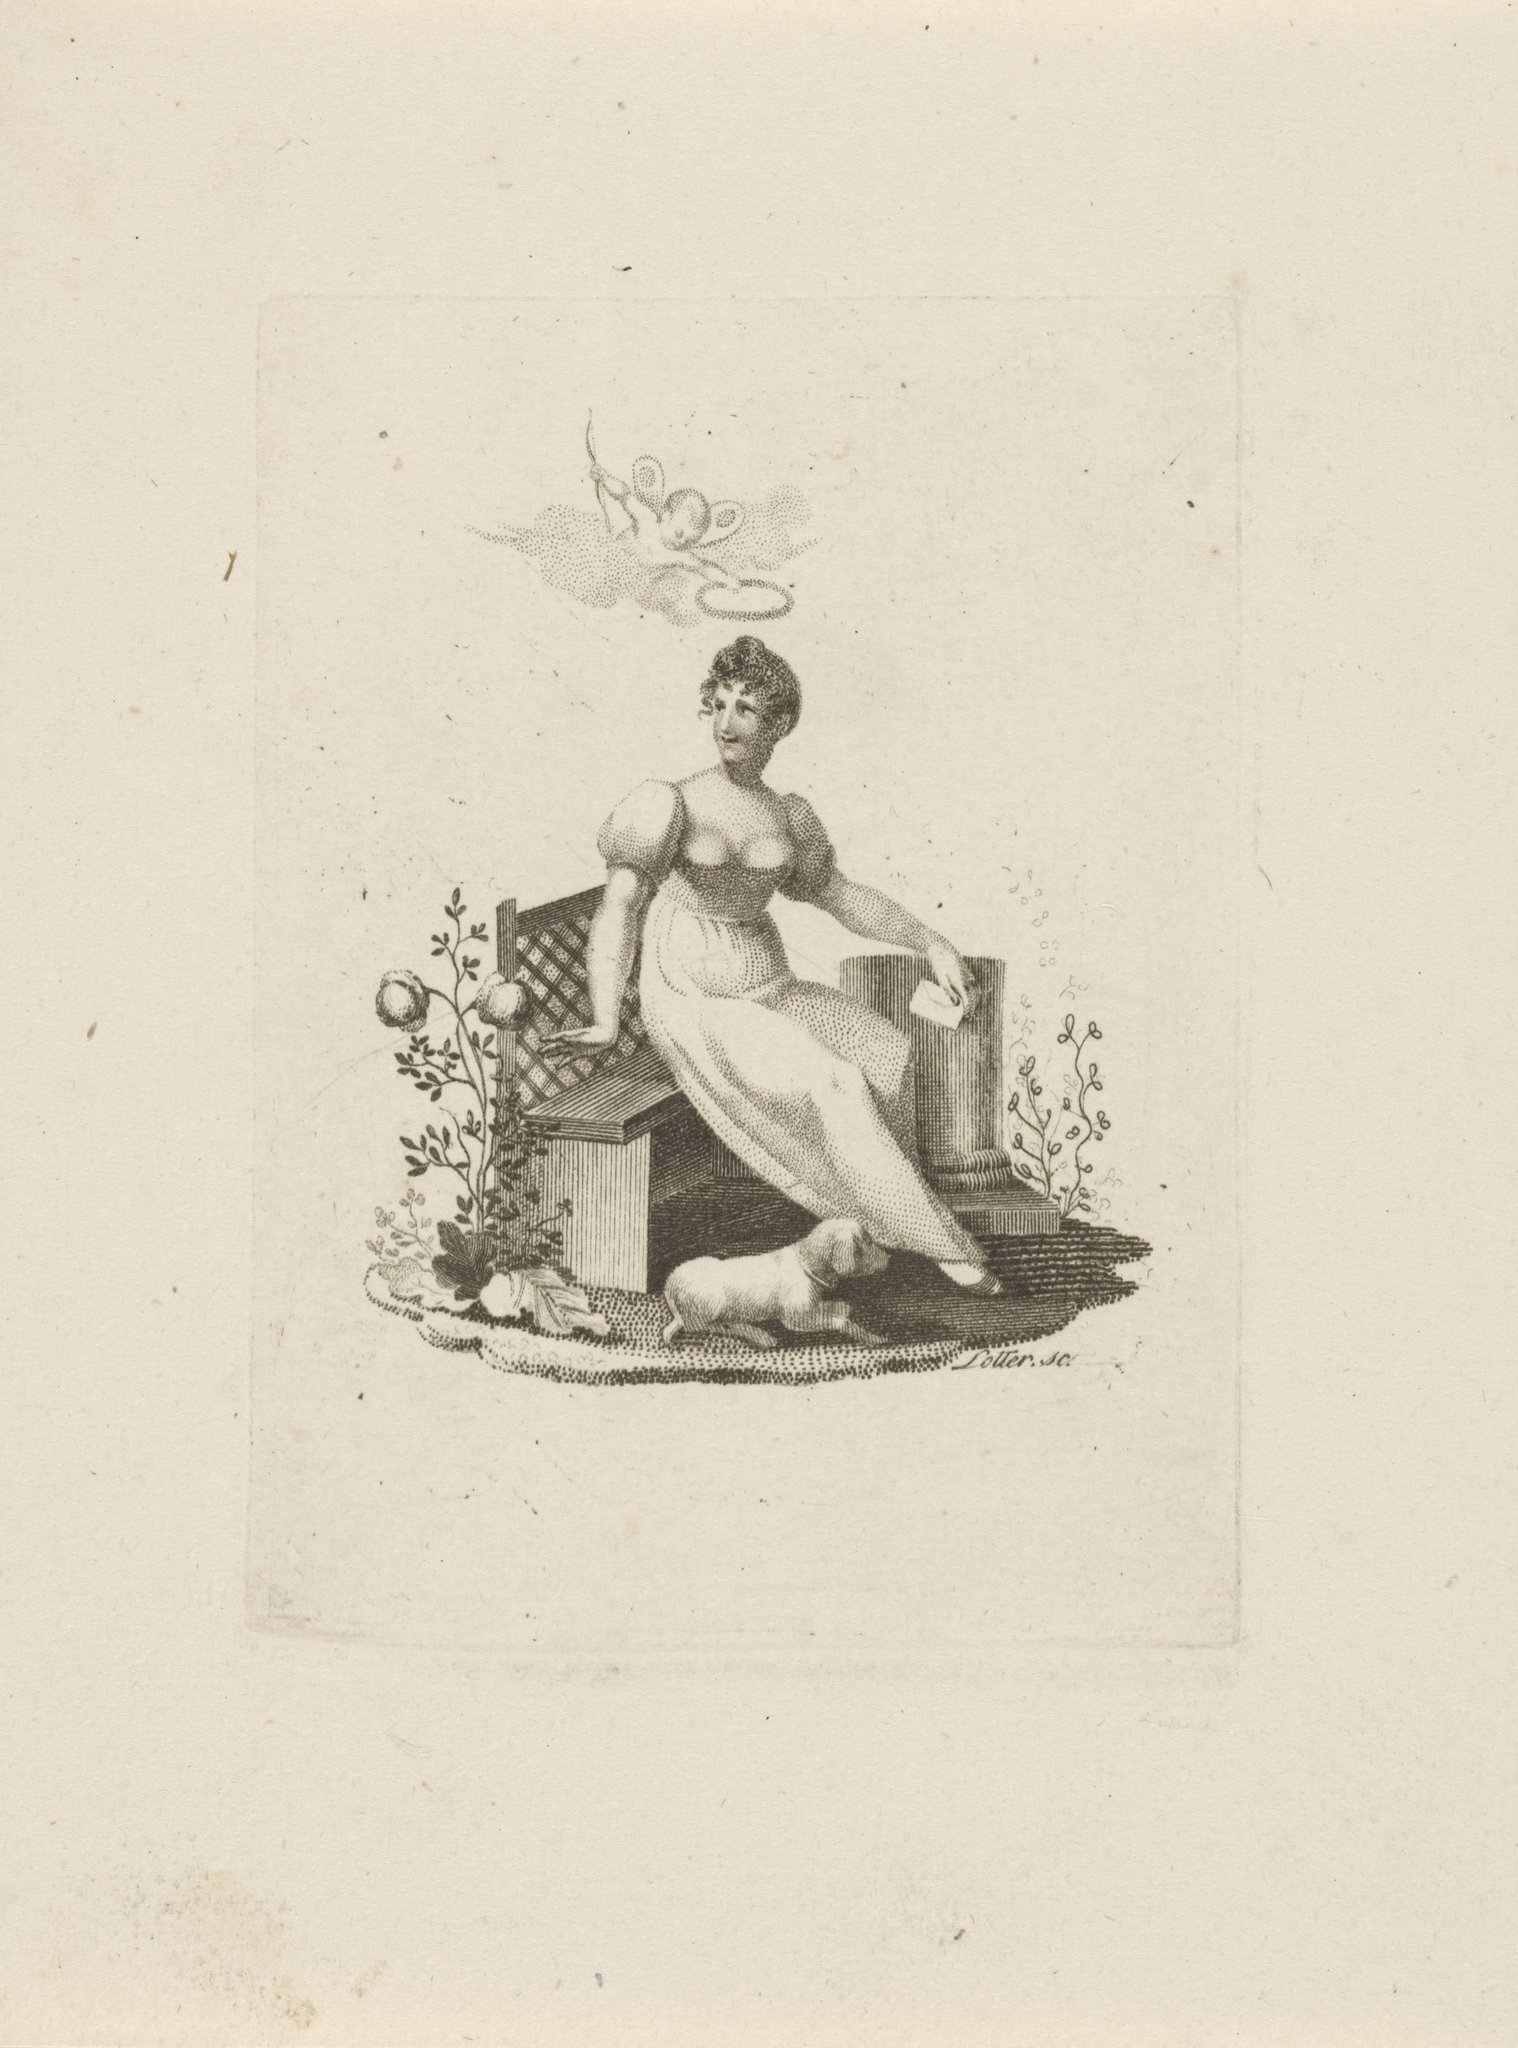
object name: print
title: Vrouw zittend op een bankje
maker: christian anthony lotter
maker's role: print maker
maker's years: 1787-1838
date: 1797-1838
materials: paper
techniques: engraving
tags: sitting figure - aa - female human figure, cupids: 'amores', 'amoretti', 'putti', dog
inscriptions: collector's mark: Lugt 2760, collector's mark: Lugt 2228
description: Een jonge vrouw zit op een bankje in de openlucht met een brief in haar handen. In de lucht boven haar vliegt een putto met een lauwerkrans. Bij haar voeten ligt een hond.